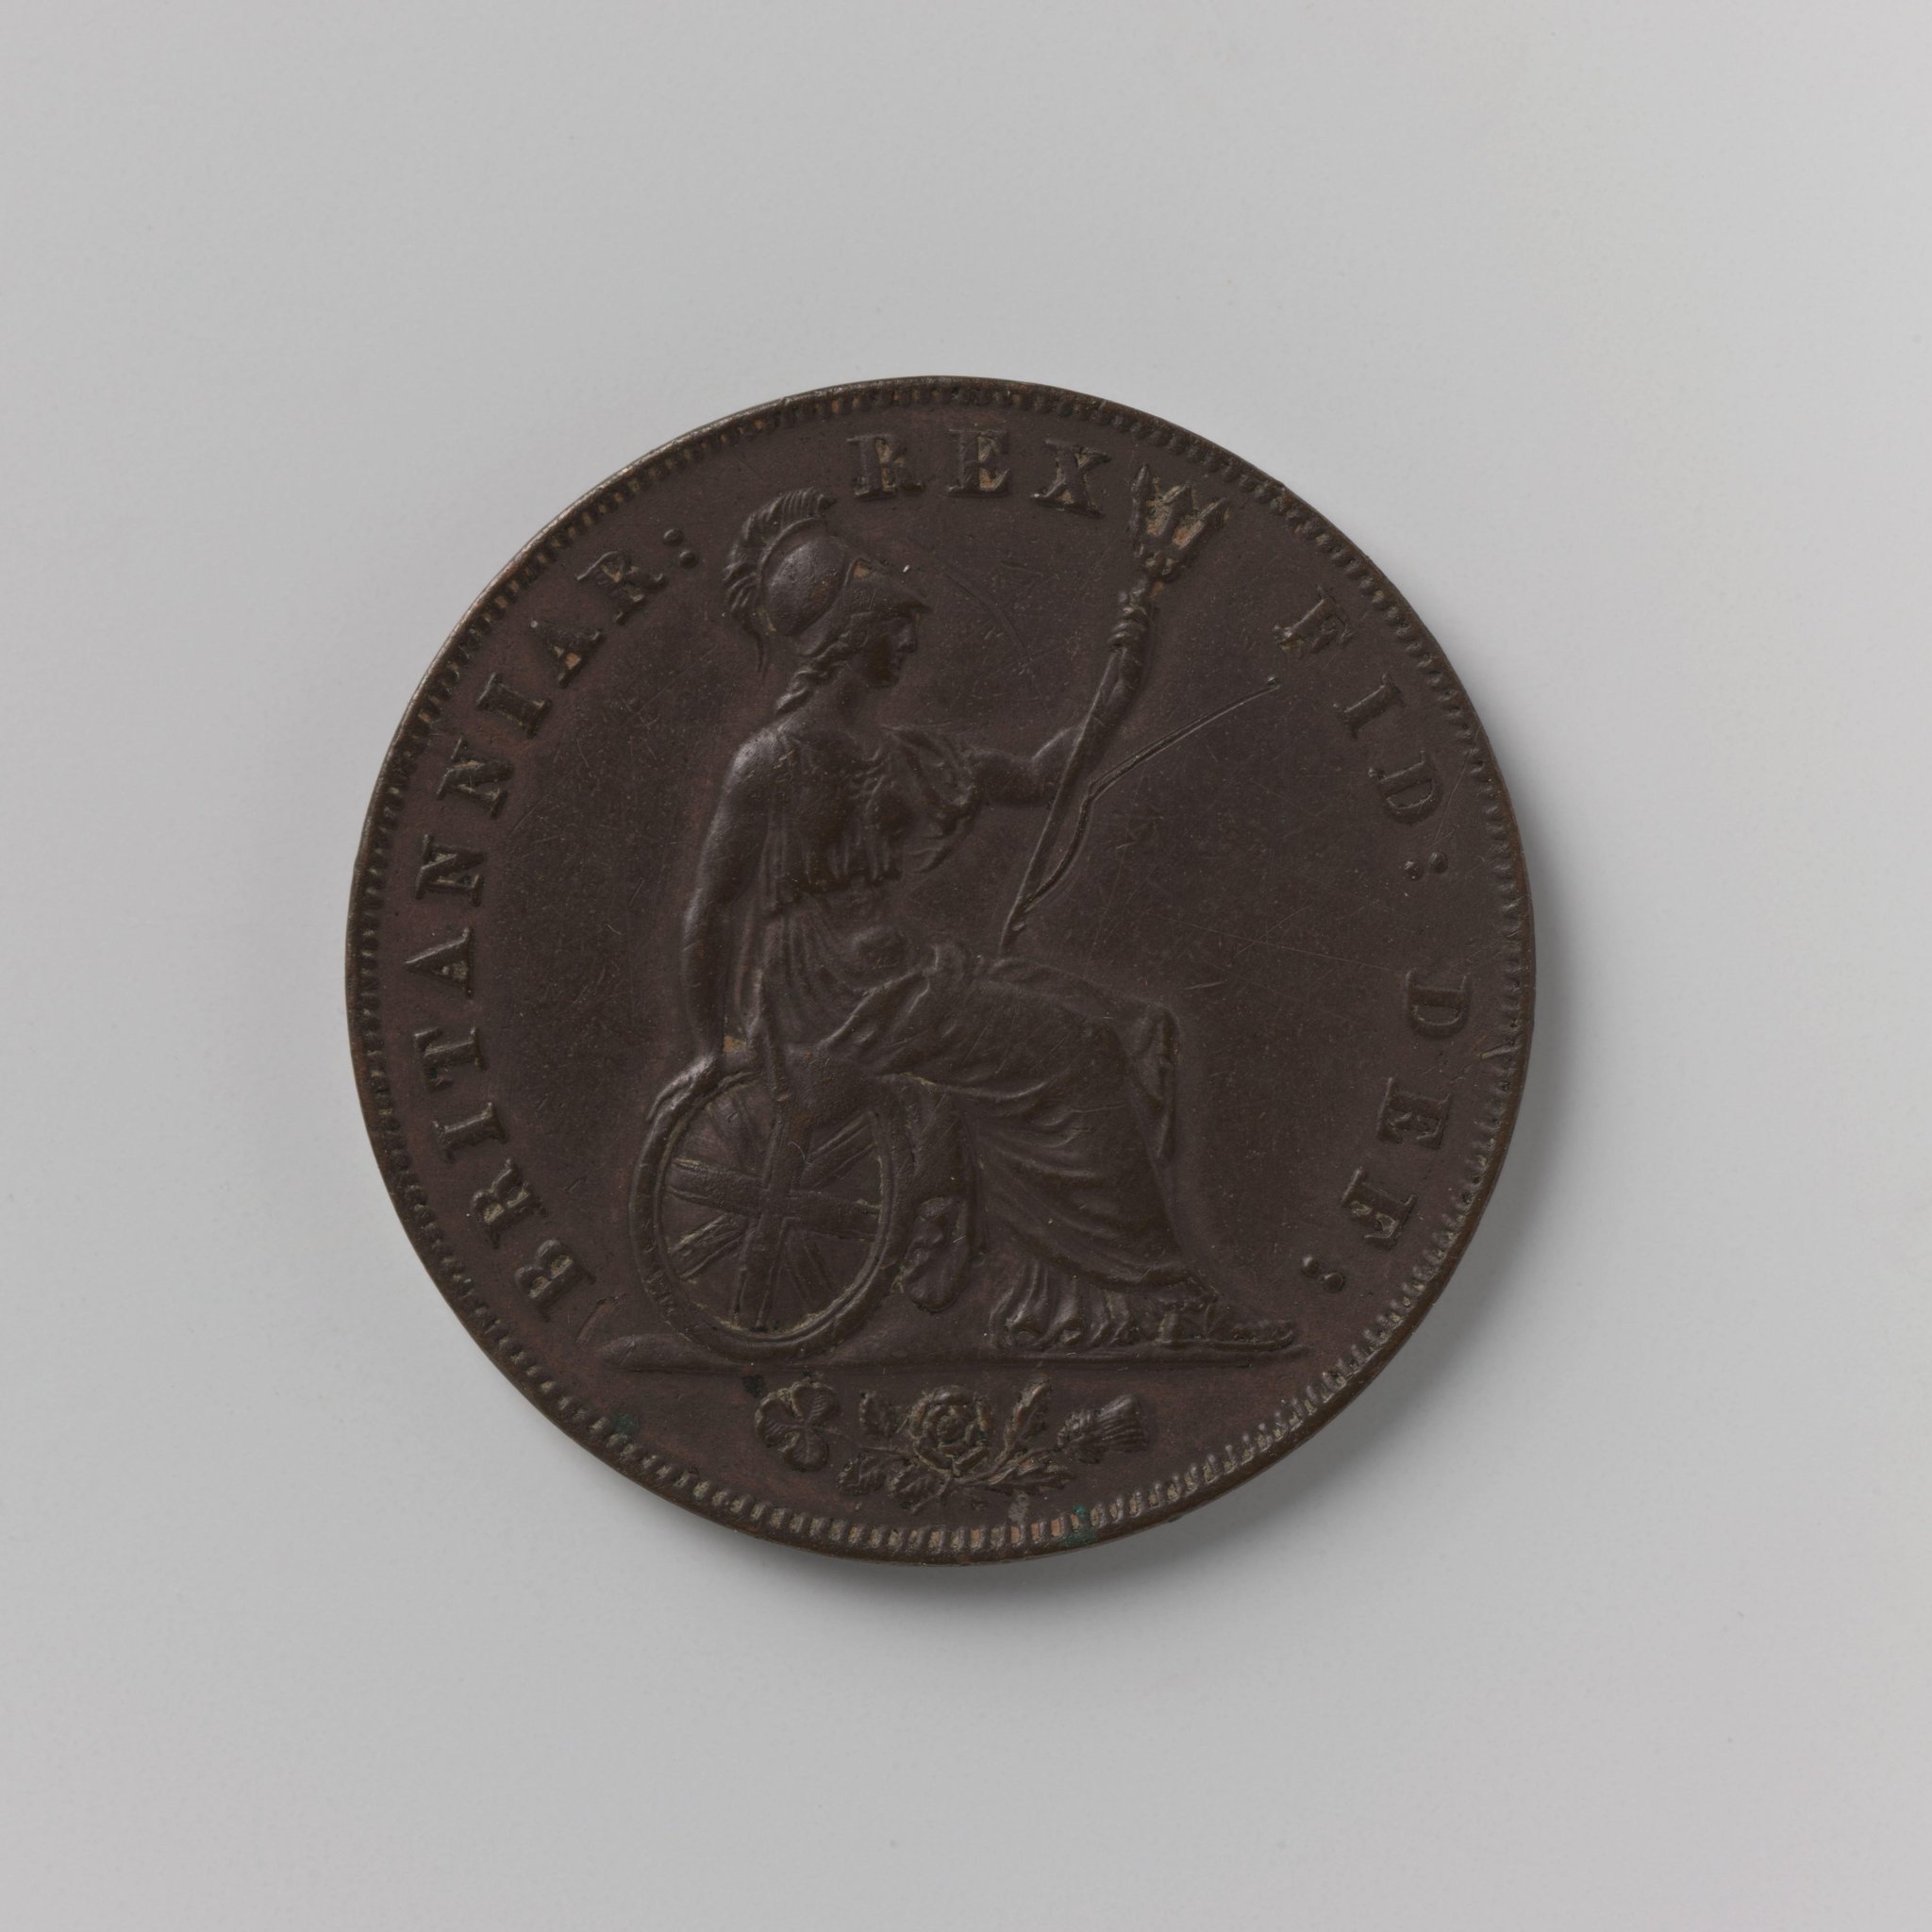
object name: coin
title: Engeland, George IV, ½ penny, 1826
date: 1826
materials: copper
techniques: striking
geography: london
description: Koperen munt. Voorzijde: gelauwerd hoofd van de koning naar links. Jaartal in omschrift onderaan. Keerzijde: gezeten Brittannia met wapenschild met drietand, naar rechts. In afsnede klaverblad, roos en distel. Gladde rand.